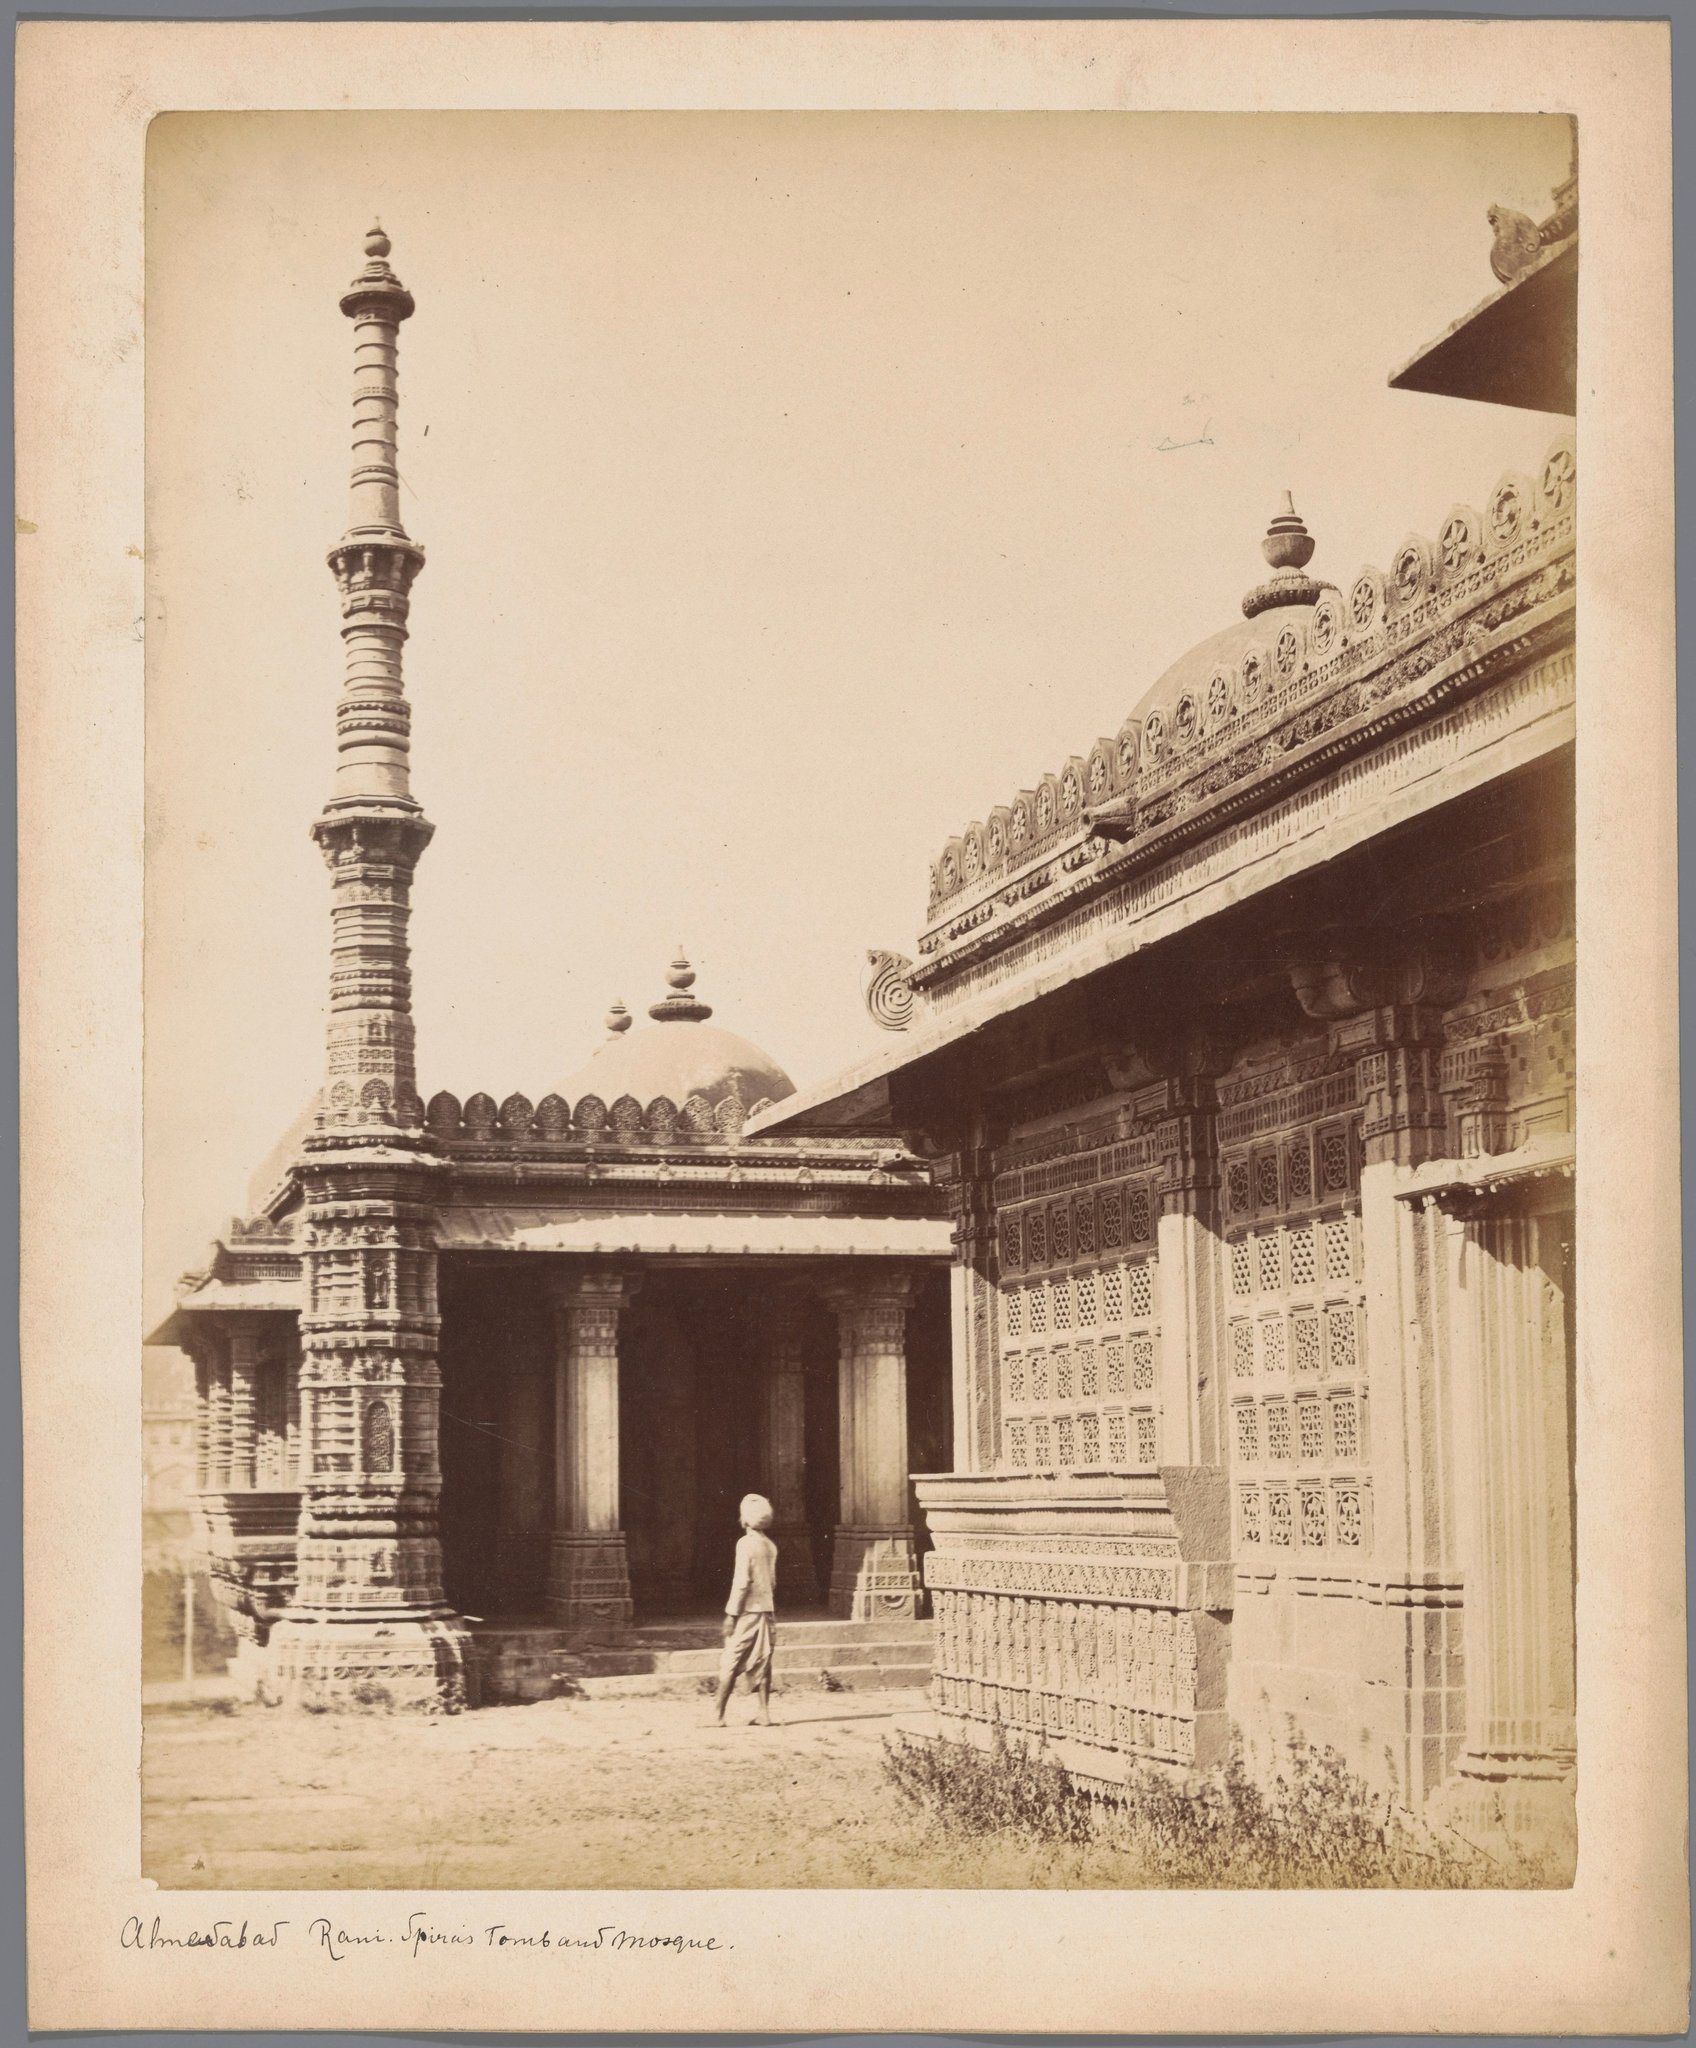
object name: photograph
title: View of Rani Sipri's mosque at Ahmedabad, Gujarat, India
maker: Anonymous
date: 1865-1890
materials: cardboard, paper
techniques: albumen print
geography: ahmedabad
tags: temple, shrine ~ islam, mohammedanism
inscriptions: number: ‘19’, title: ‘Ahmedabad Rani Spira's Tomb and Mosque’